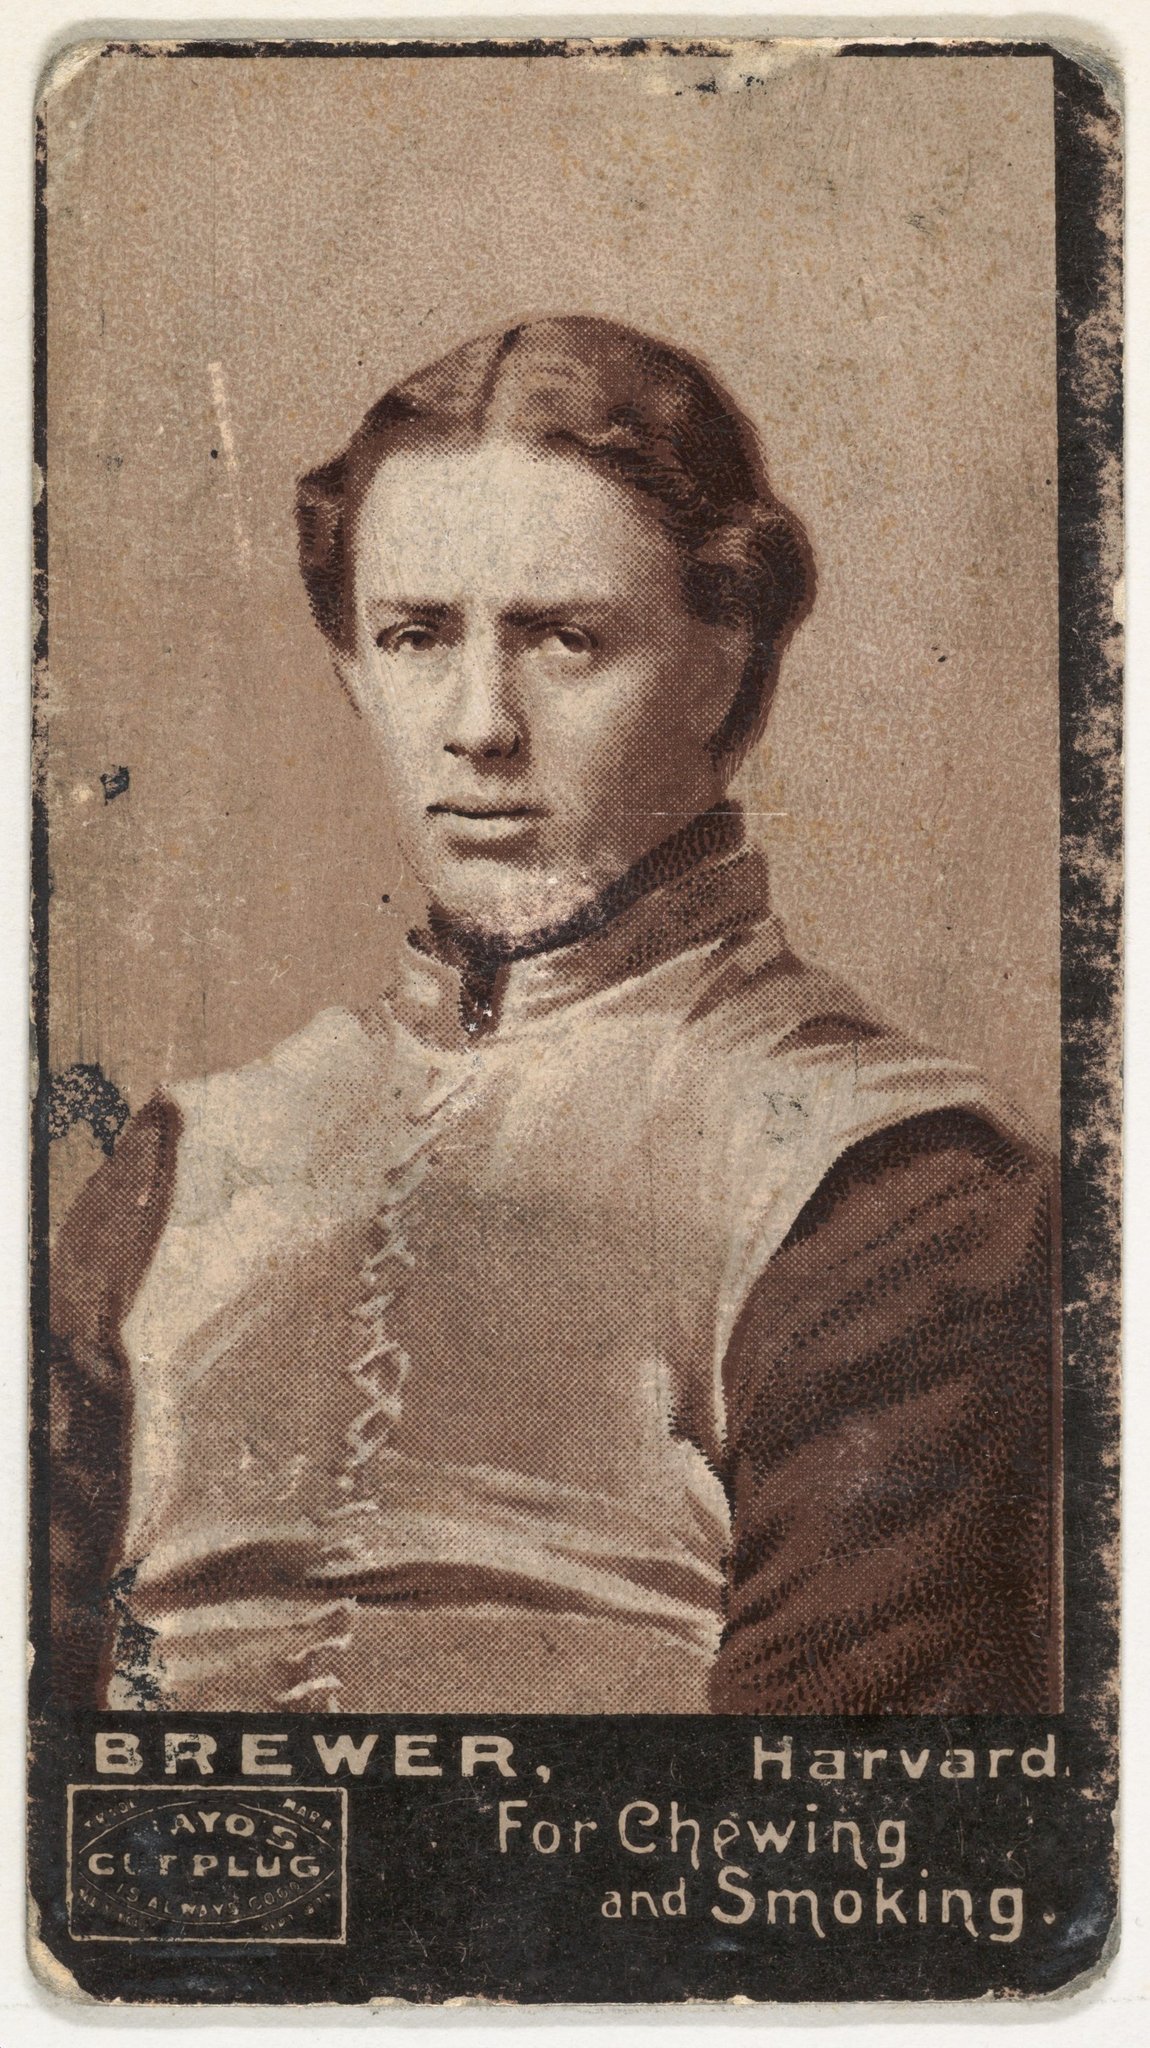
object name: print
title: Brewer, Harvard University, from the College Football Stars series (N302) for Mayo's Cut Plug Tobacco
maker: p.h. mayo & brother, richmond, virginia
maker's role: publisher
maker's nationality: american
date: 1894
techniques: lithography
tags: men,portraits,football,athletes